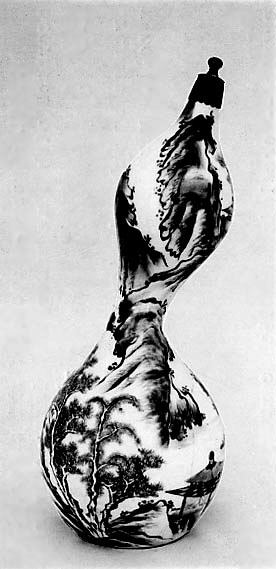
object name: bottle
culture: japanese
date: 1701-1800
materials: cobalt, porcelain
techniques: underglaze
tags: houses,mountains